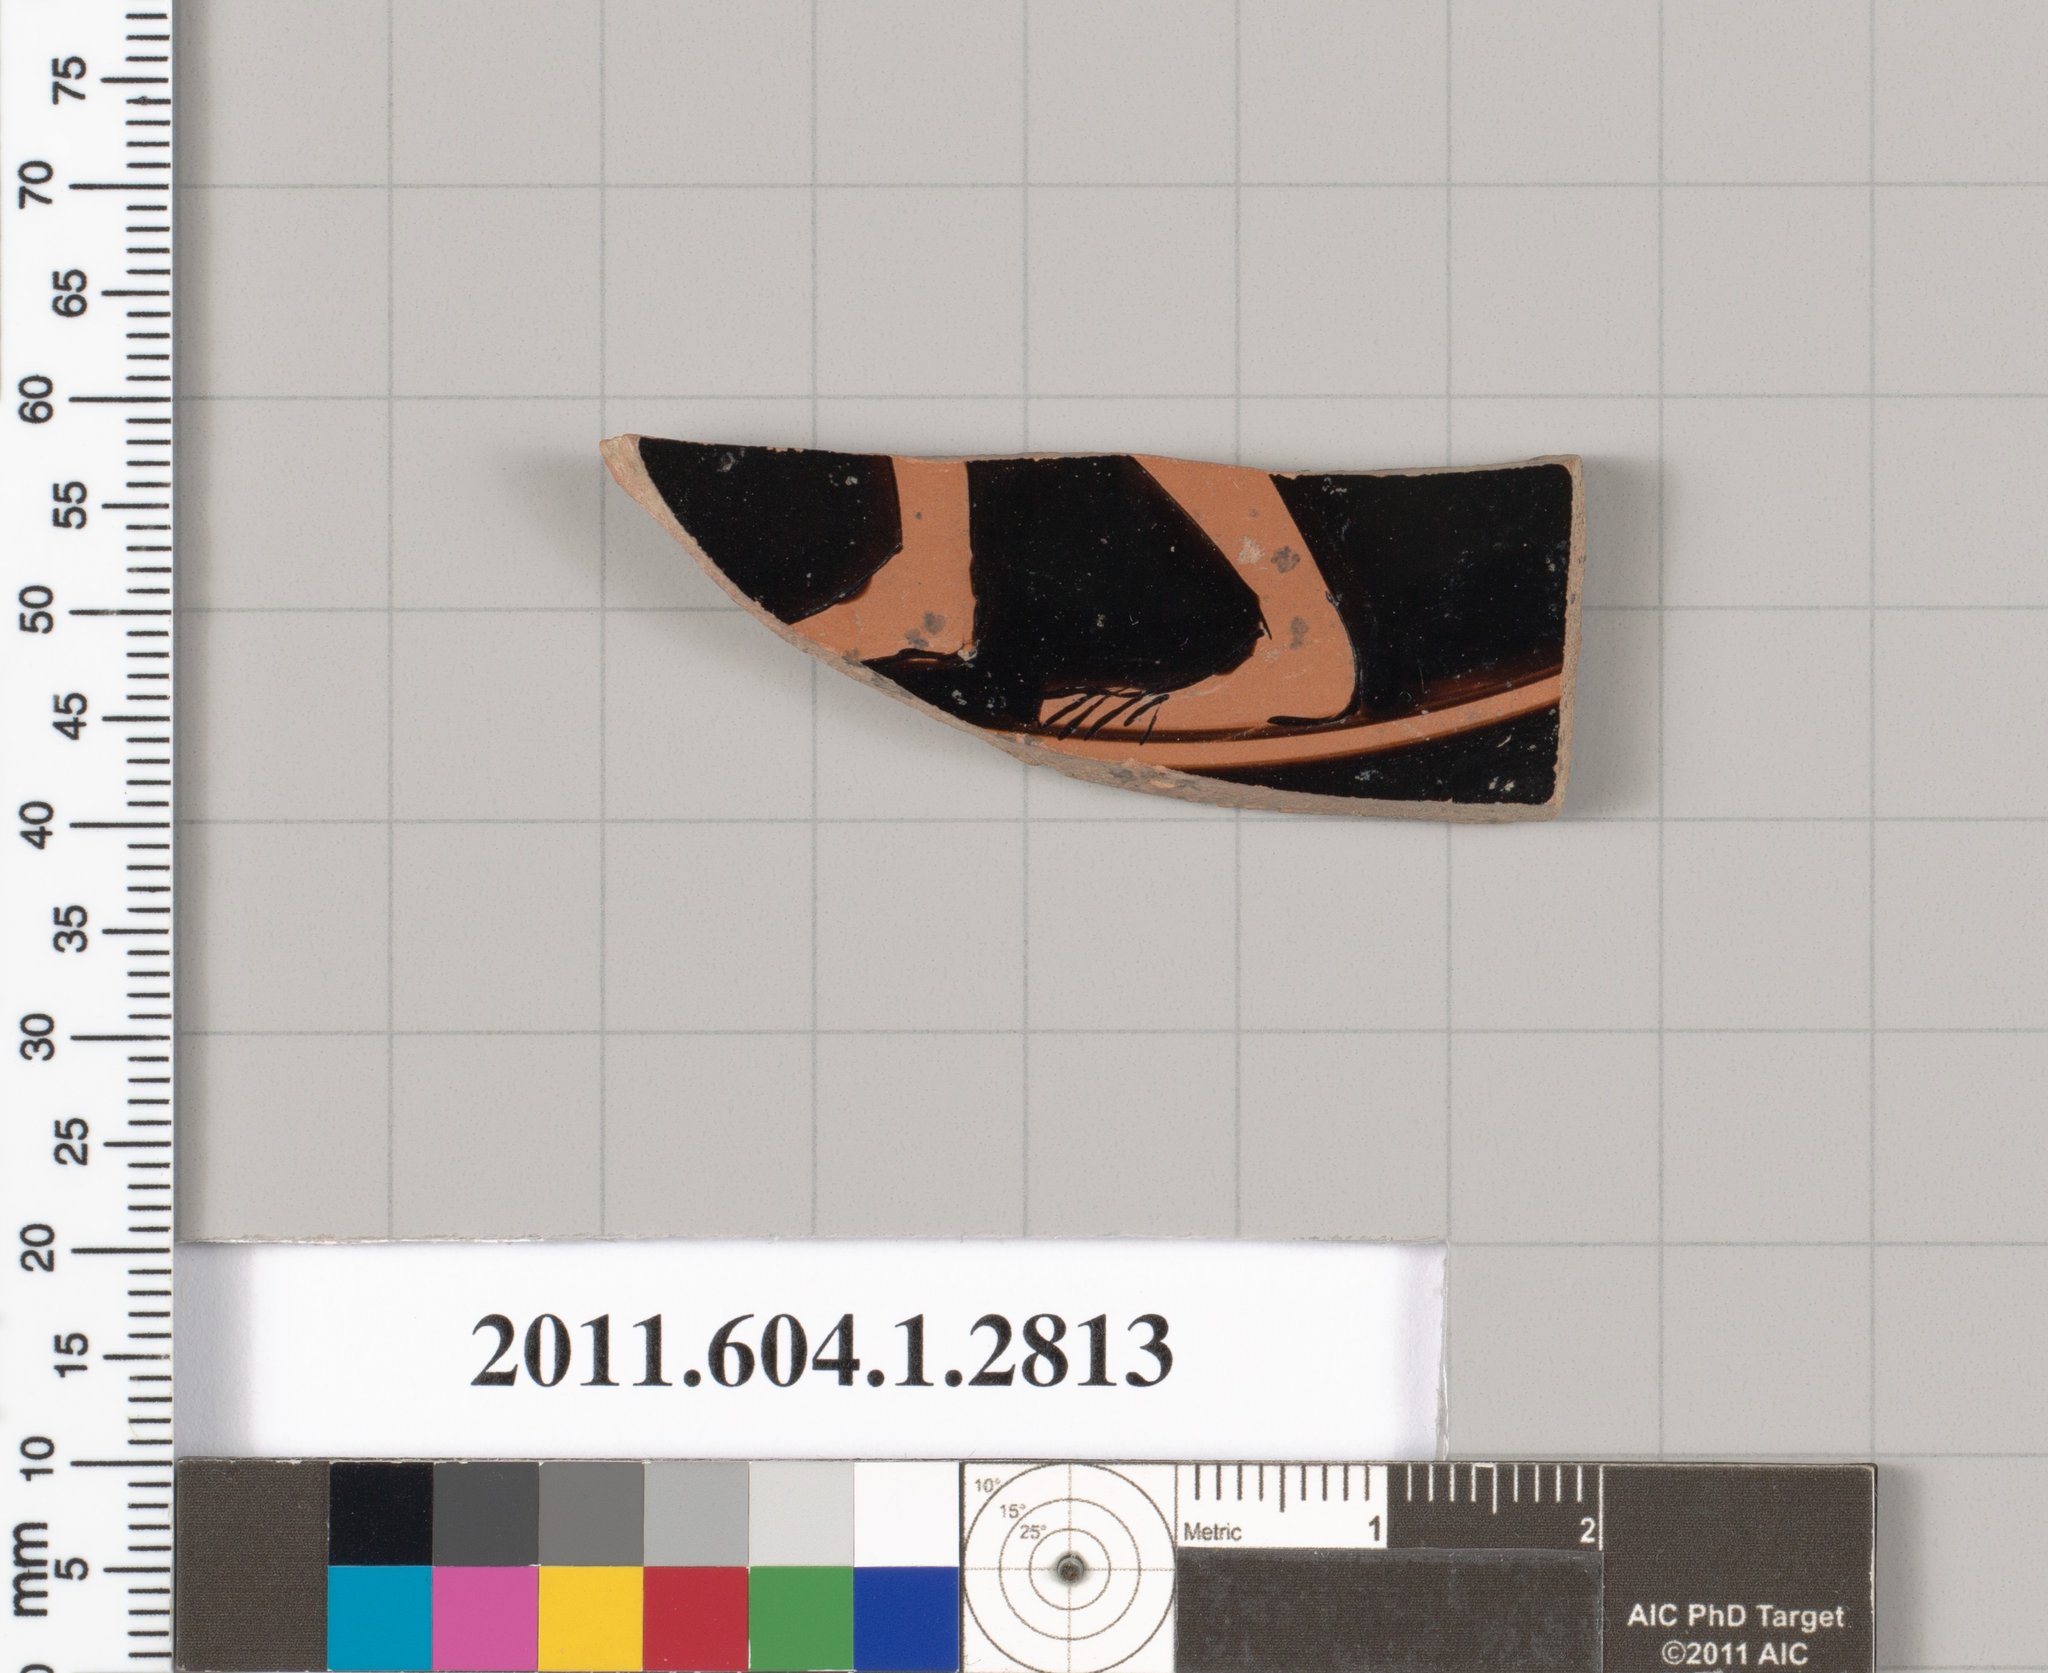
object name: kylix fragment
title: Terracotta fragment of a kylix (drinking cup)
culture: greek, attic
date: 520-500 BCE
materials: terracotta